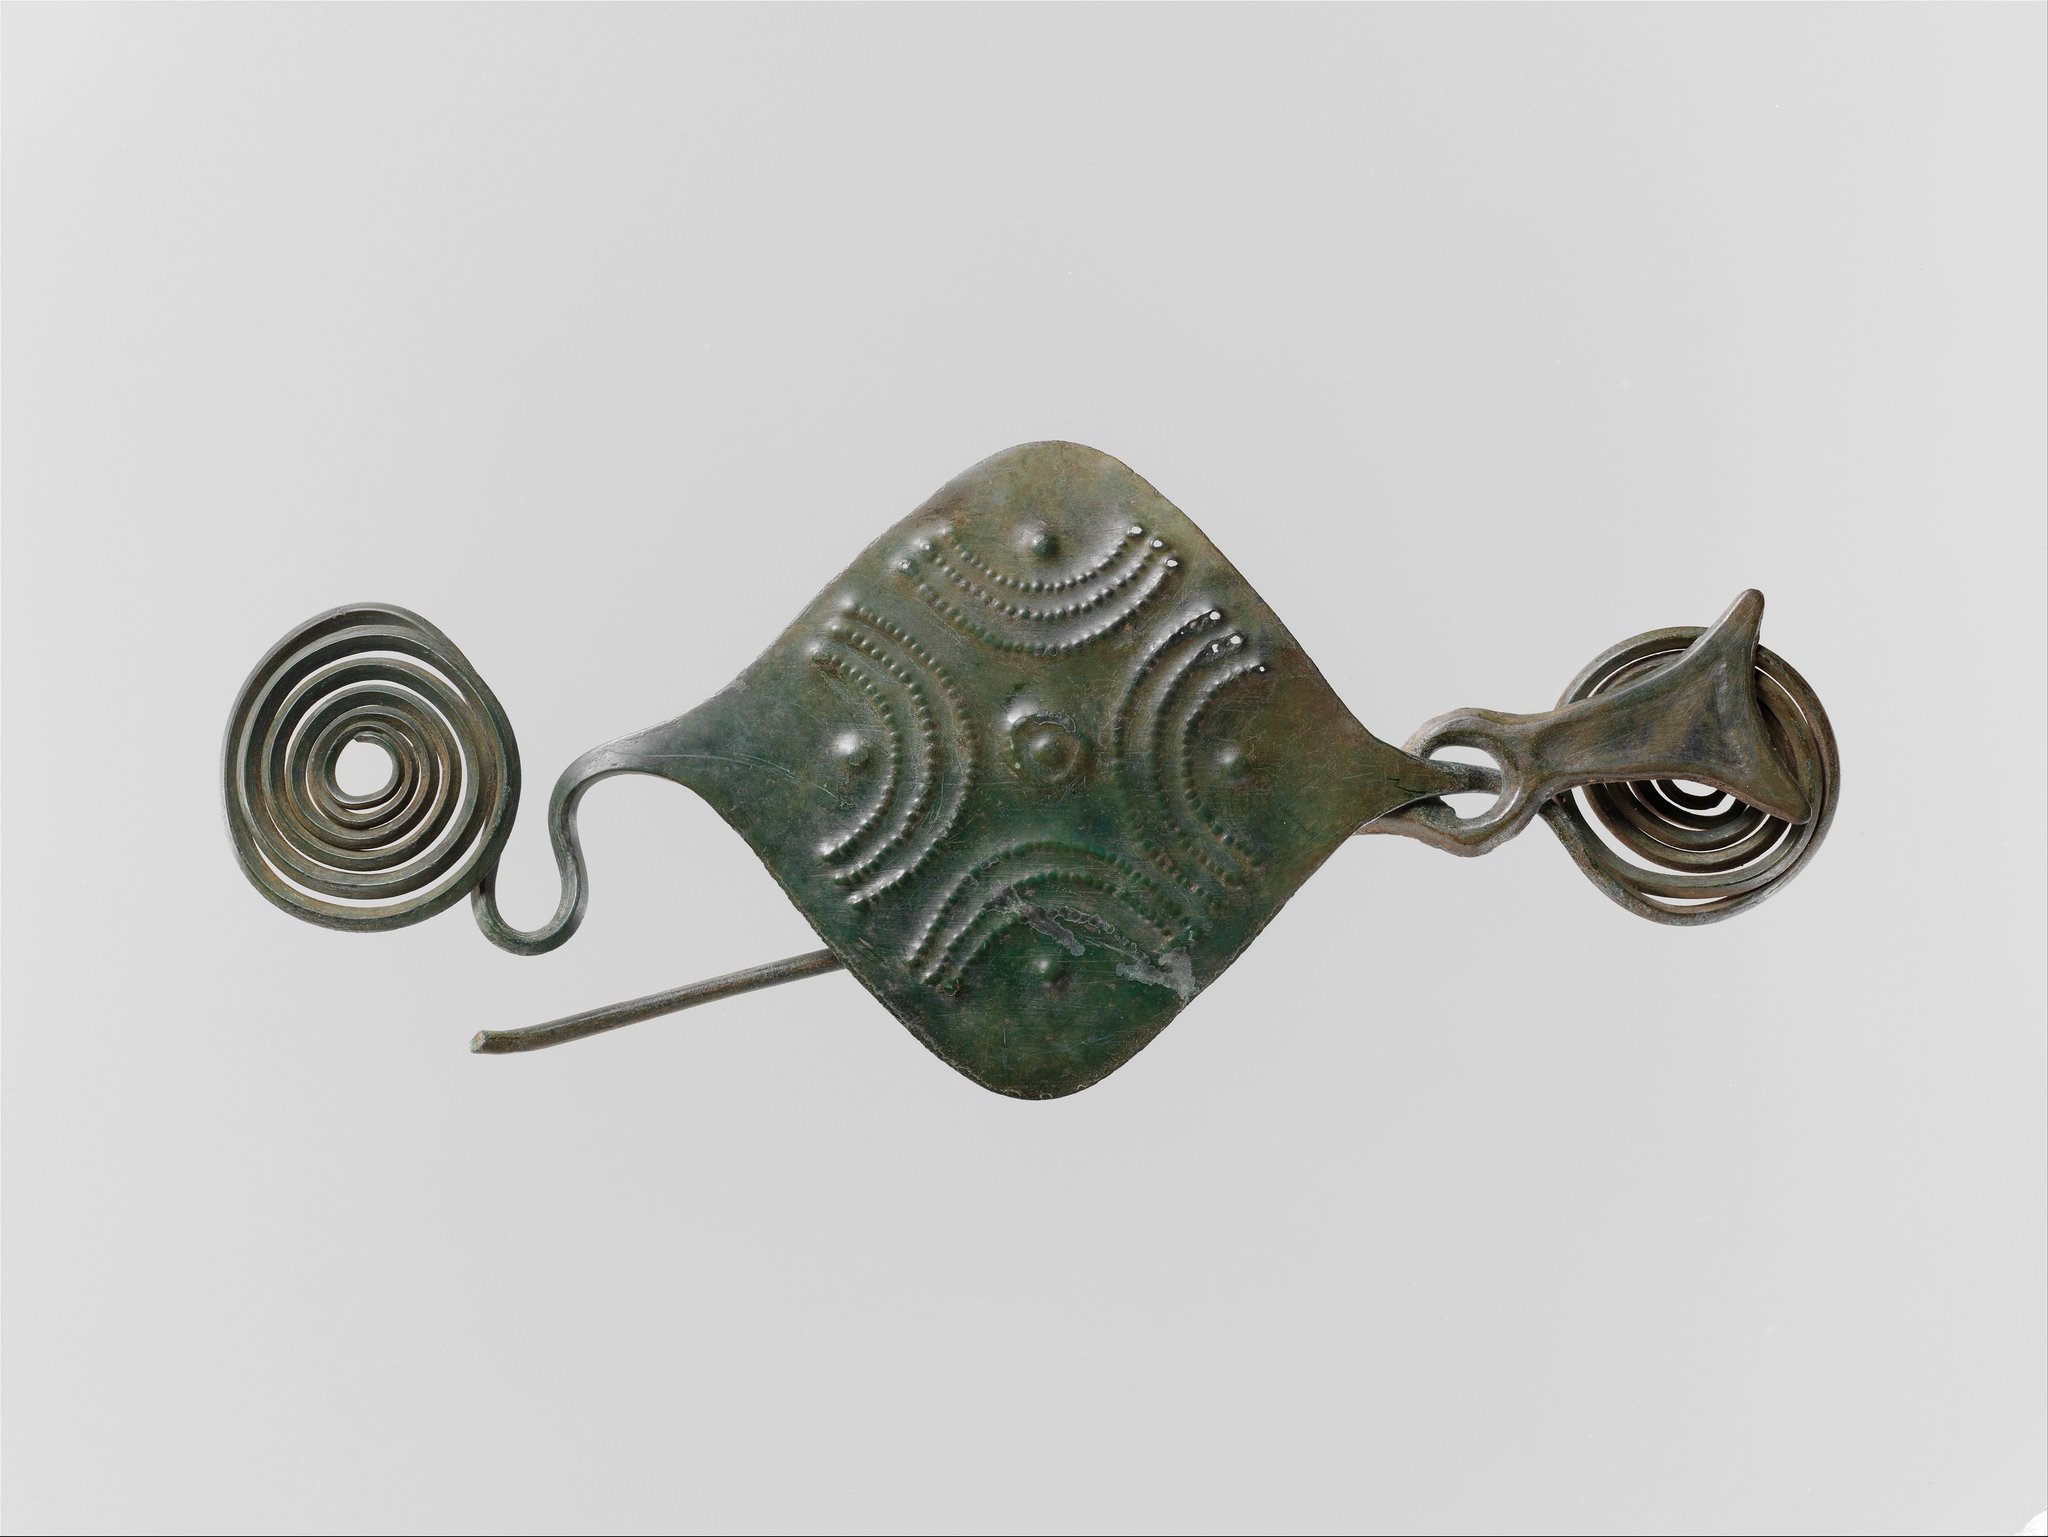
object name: brooch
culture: european bronze age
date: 1100-1001 BCE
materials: copper alloy